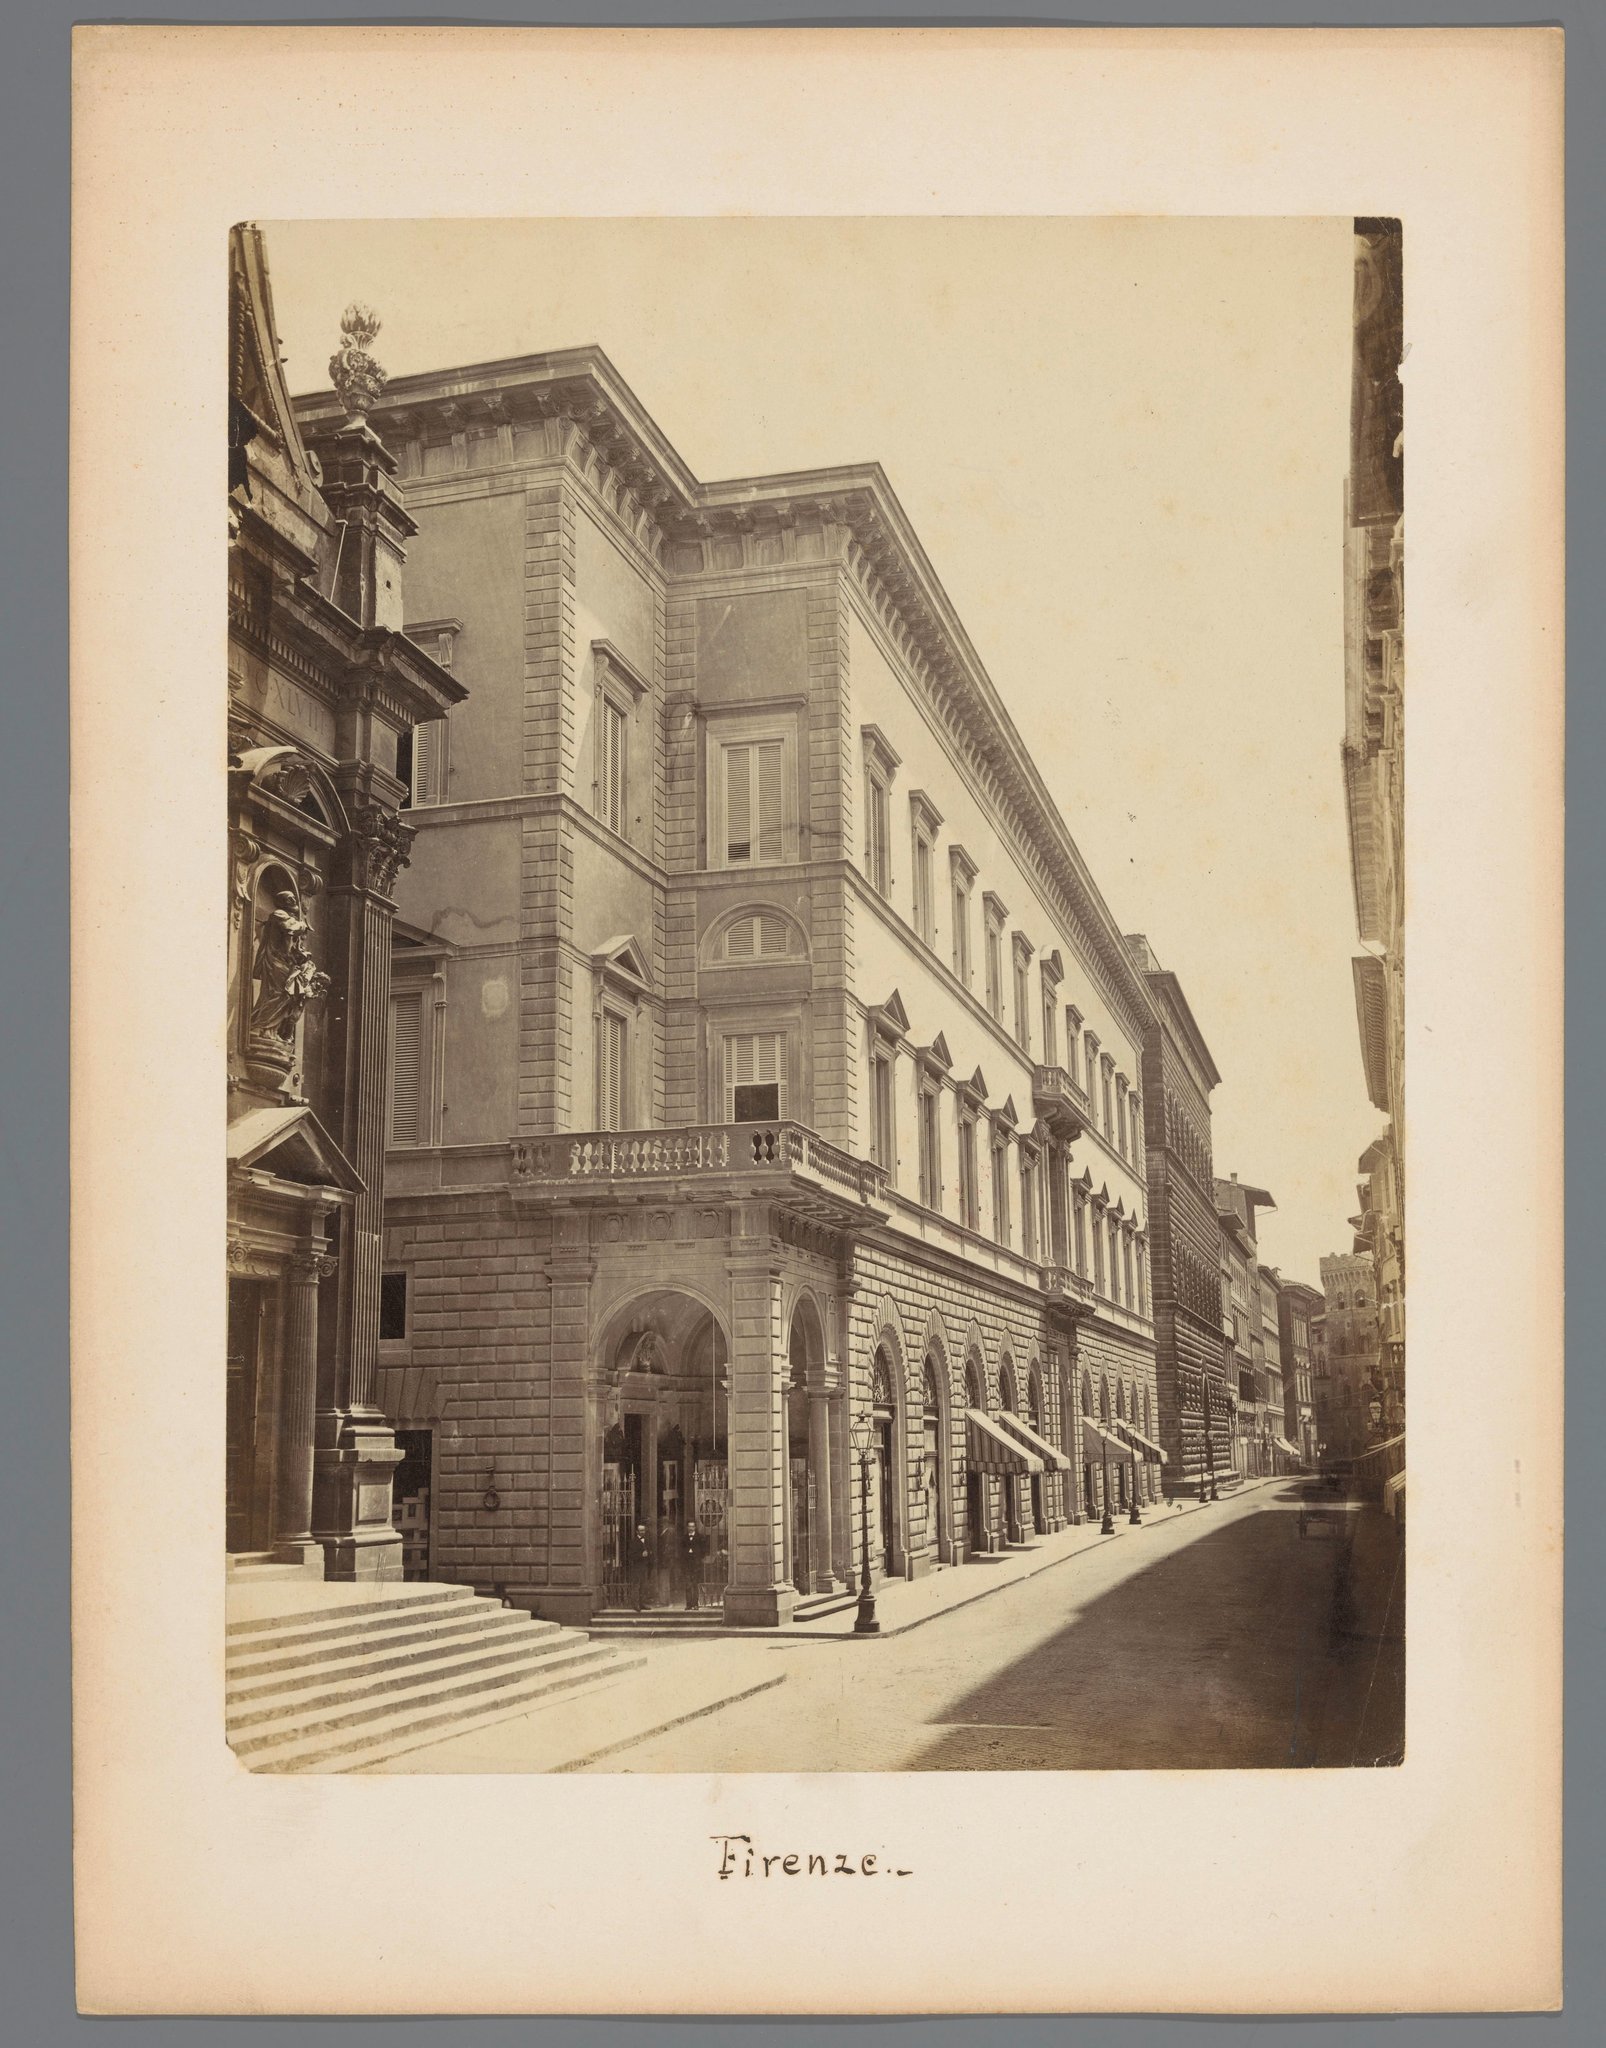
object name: photograph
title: Firenze.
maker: Anonymous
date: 1875-1900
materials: cardboard, photographic support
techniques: albumen print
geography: florence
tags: church (exterior), façade (of house or building), street, shop-window, show-window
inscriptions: collector's mark: Lugt 3937